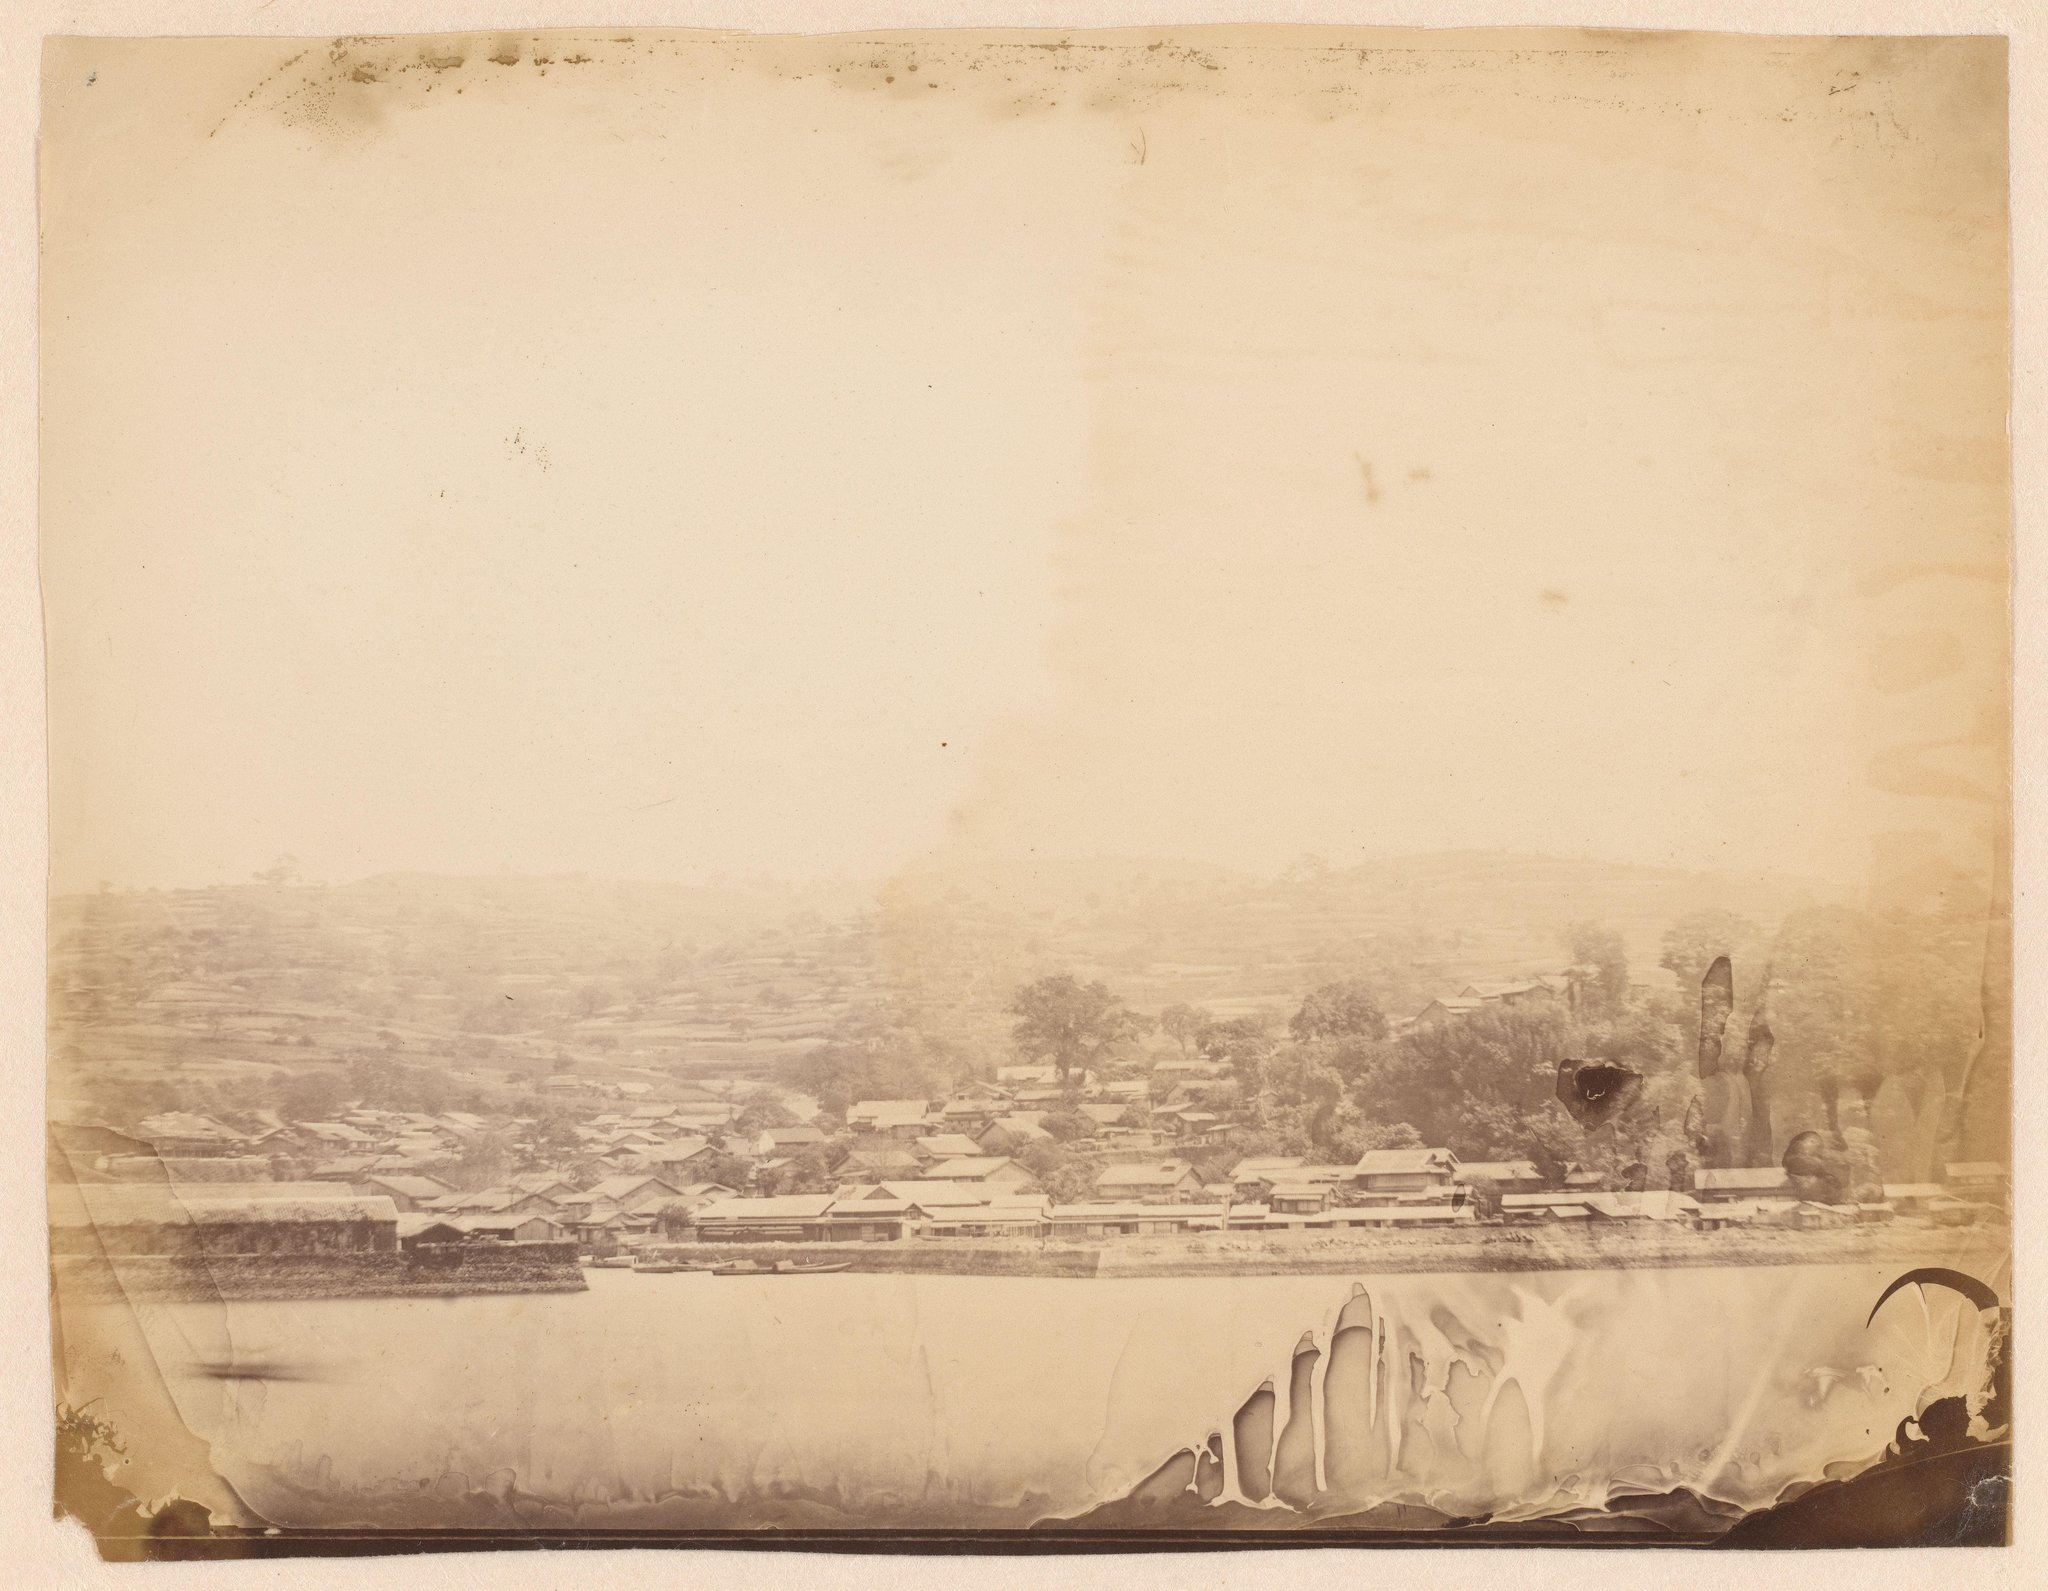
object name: photograph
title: Oever van de baai van Nagasaki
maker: antoon bauduin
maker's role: amateurfotograaf, hoogleraar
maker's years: 1820-1885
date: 1862-1866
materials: paper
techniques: albumen print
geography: japan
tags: gulf, bay, japan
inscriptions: number: ‘131’